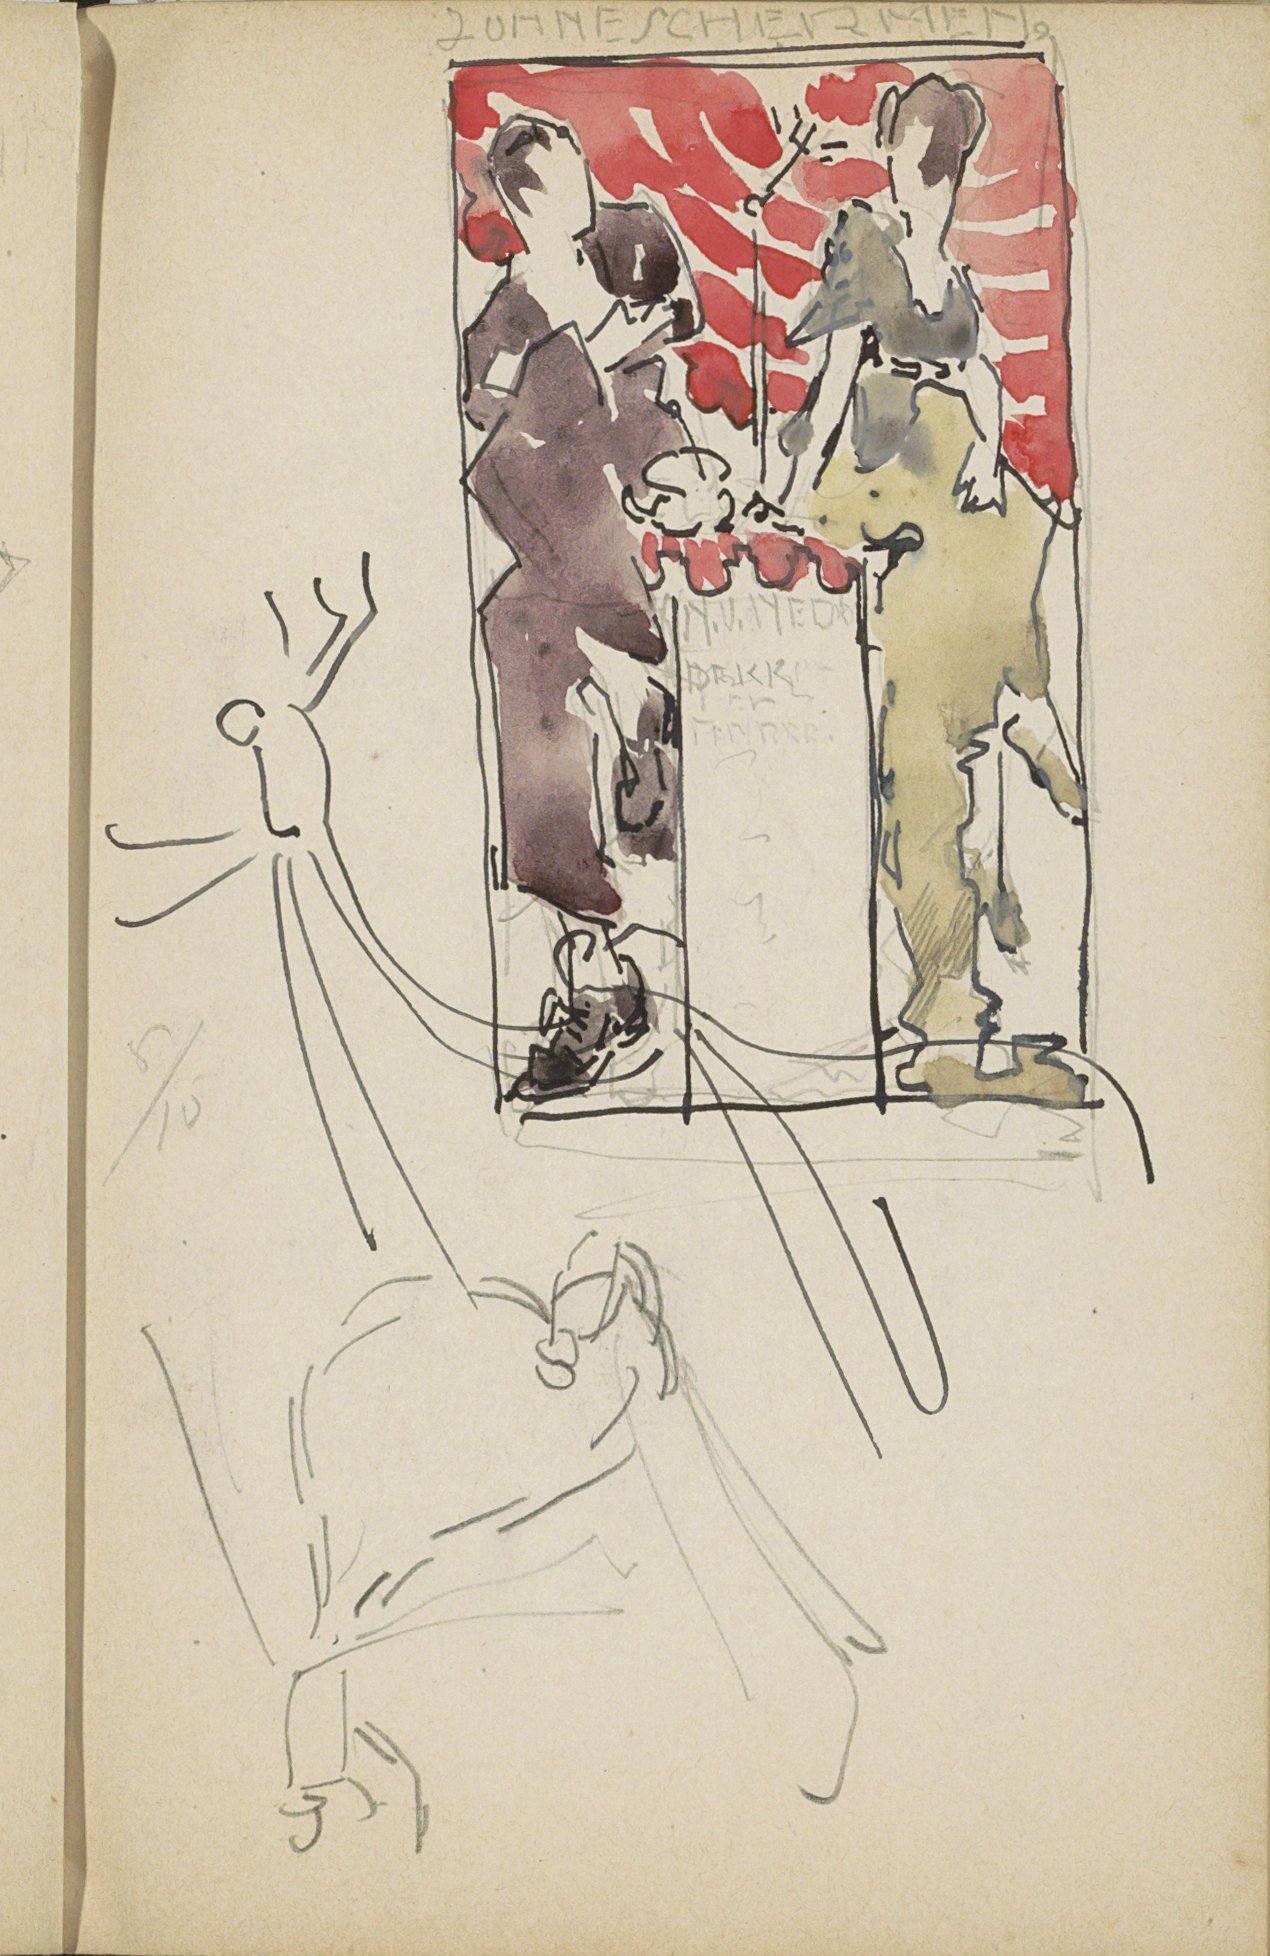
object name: sketchbook leaf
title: Reclameontwerp voor zonneschermen en een libelle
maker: reijer stolk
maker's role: draughtsman, print maker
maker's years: 1896-1945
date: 1908-1919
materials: ink, paper, pencil, watercolor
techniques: brush, pen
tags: advertising, insects: dragon-fly, parasol, sunshade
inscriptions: annotation: ‘ZONNESCHERMEN/ N.V.IYED[...] ...]/ 5/10’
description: Het reclameontwerp toont een man en vrouw staand bij een tafel onder een parasol. Blad 16 recto uit een schetsboek met 33 bladen.